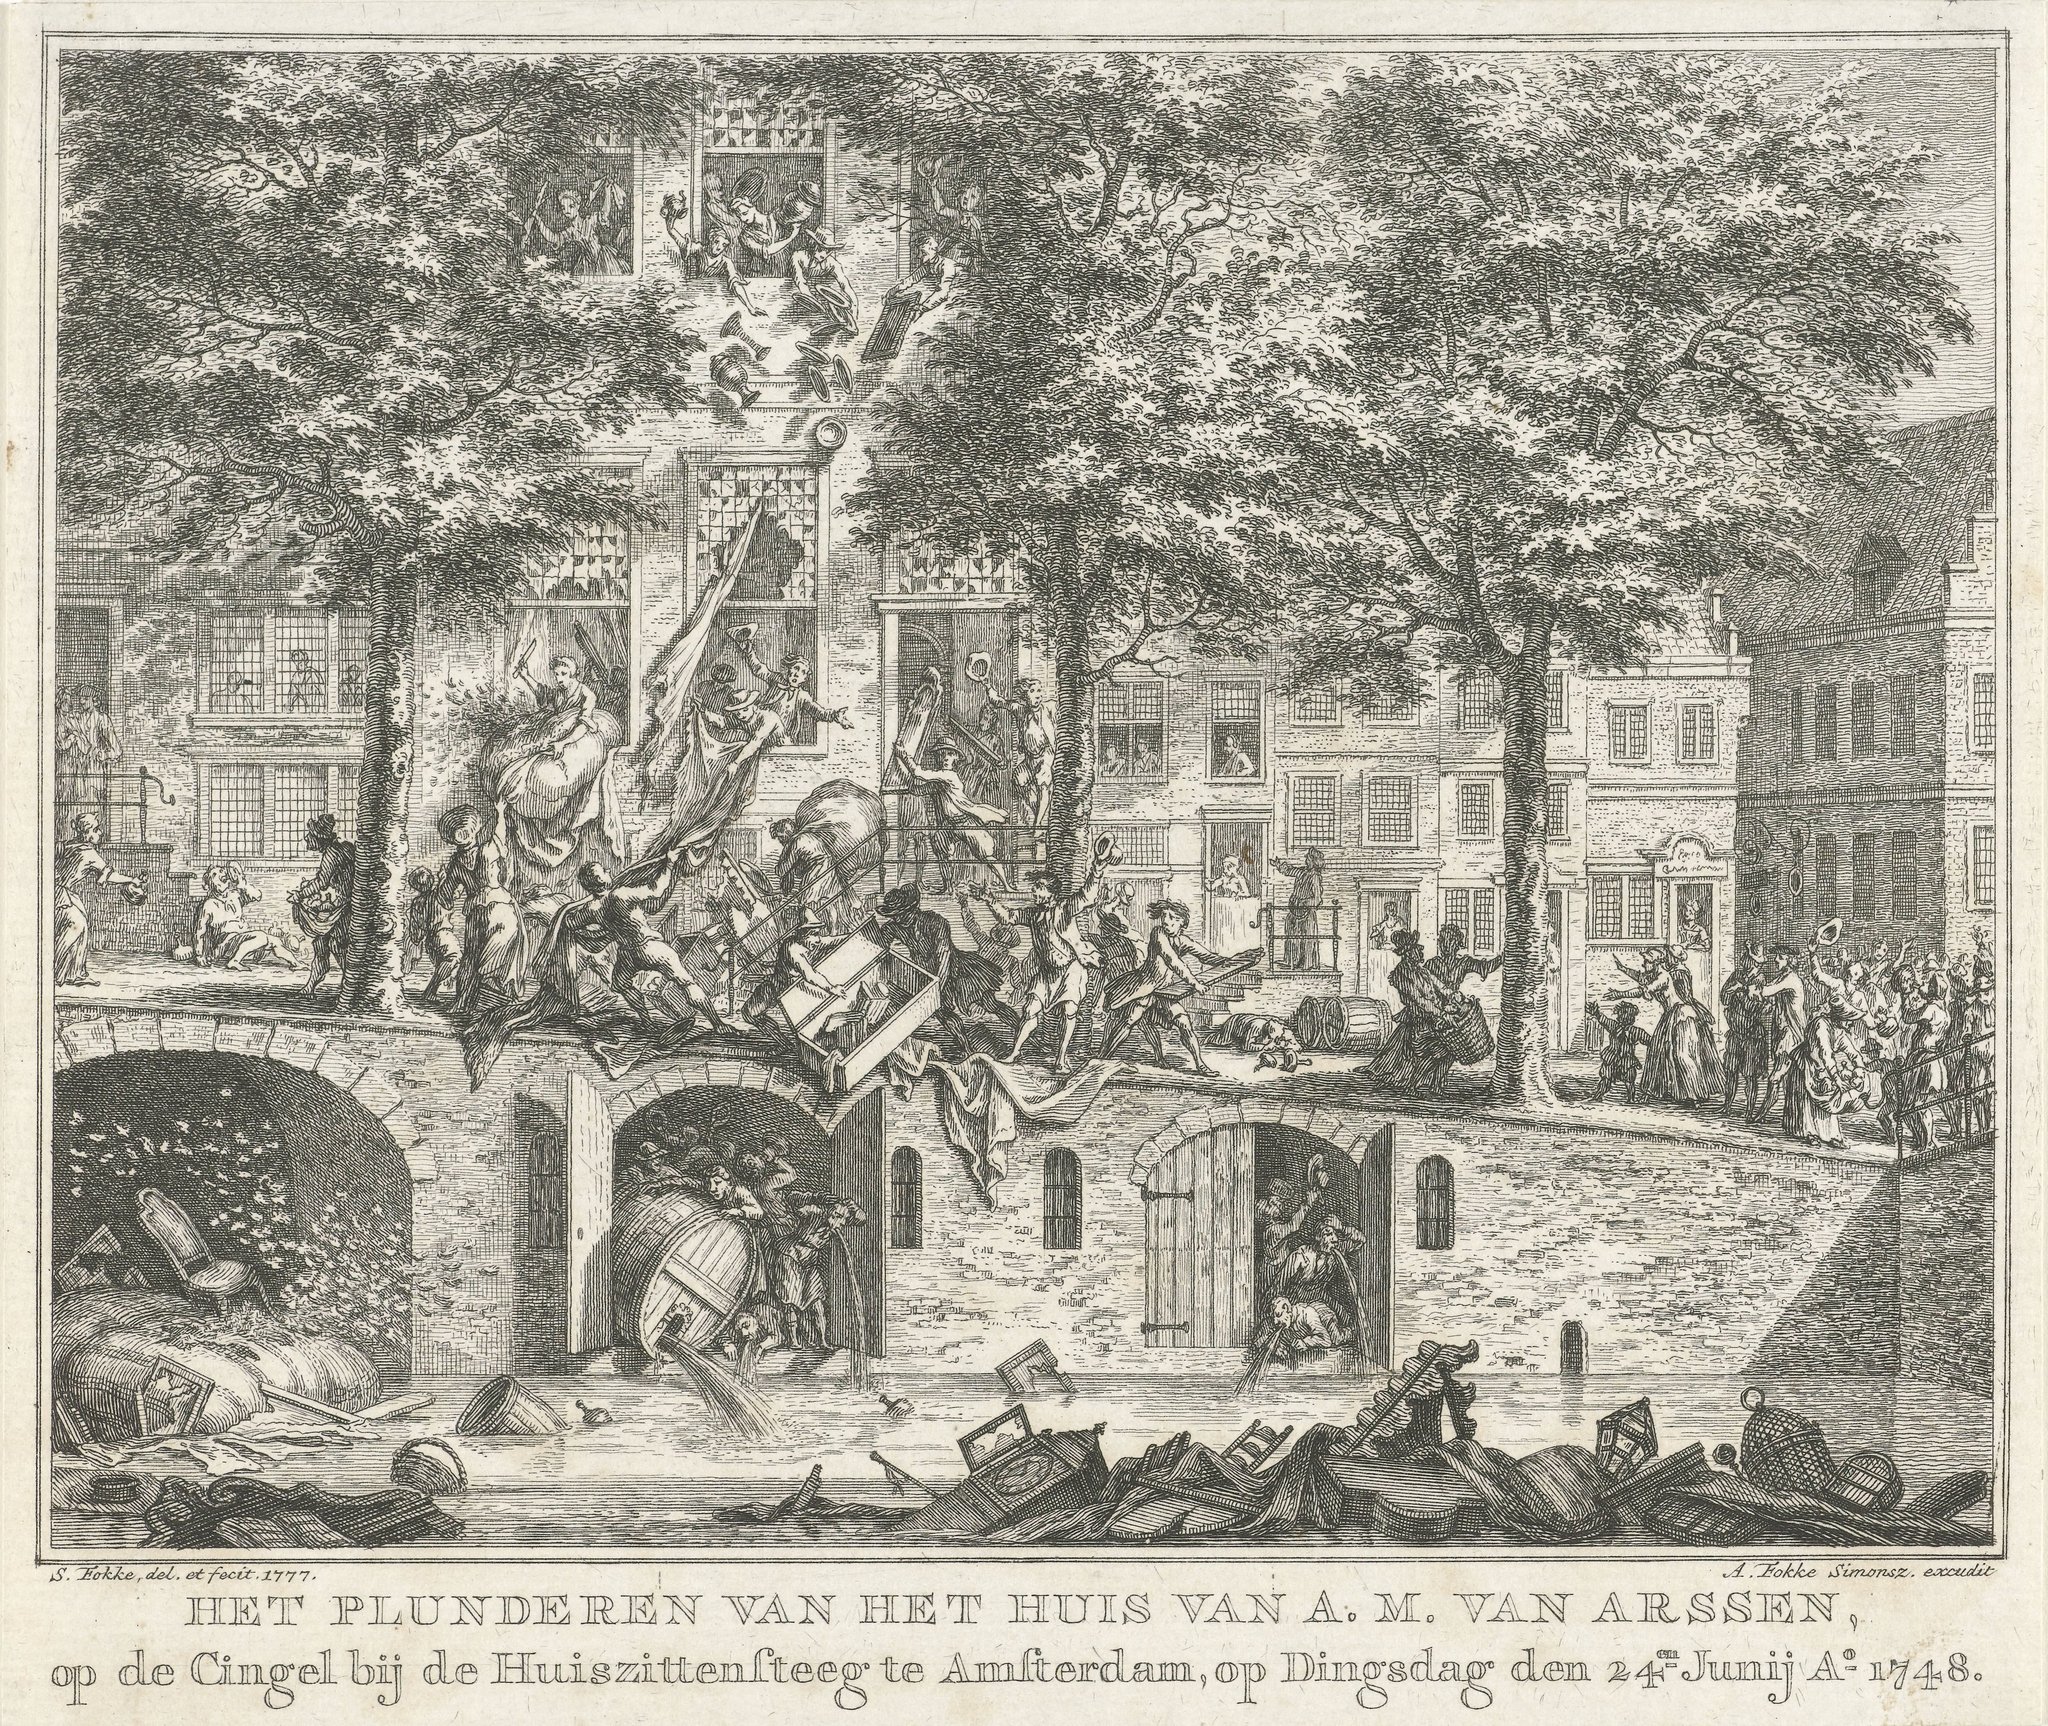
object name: print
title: Het plunderen van het huis van A.M. van Arssen, op de Cingel bij de Huiszittensteeg te Amsterdam, op Dingsdag den 24en. Junij Ao. 1748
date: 1777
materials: paper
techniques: etching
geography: northern netherlands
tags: plundering ~ riot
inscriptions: collector's mark: Lugt 2228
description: Plundering van het huis van de belastingpachter A.M. van Arssen aan de Singel te Amsterdam, op 24 of 25 juni 1748 tijdens het Pachtersoproer. Huisraad wordt op straat en in de gracht gegooid. De plunderaars doen zich te goed aan de wijn die in de kelders is opgeslagen, de wijn wordt ook in de gracht geloost.